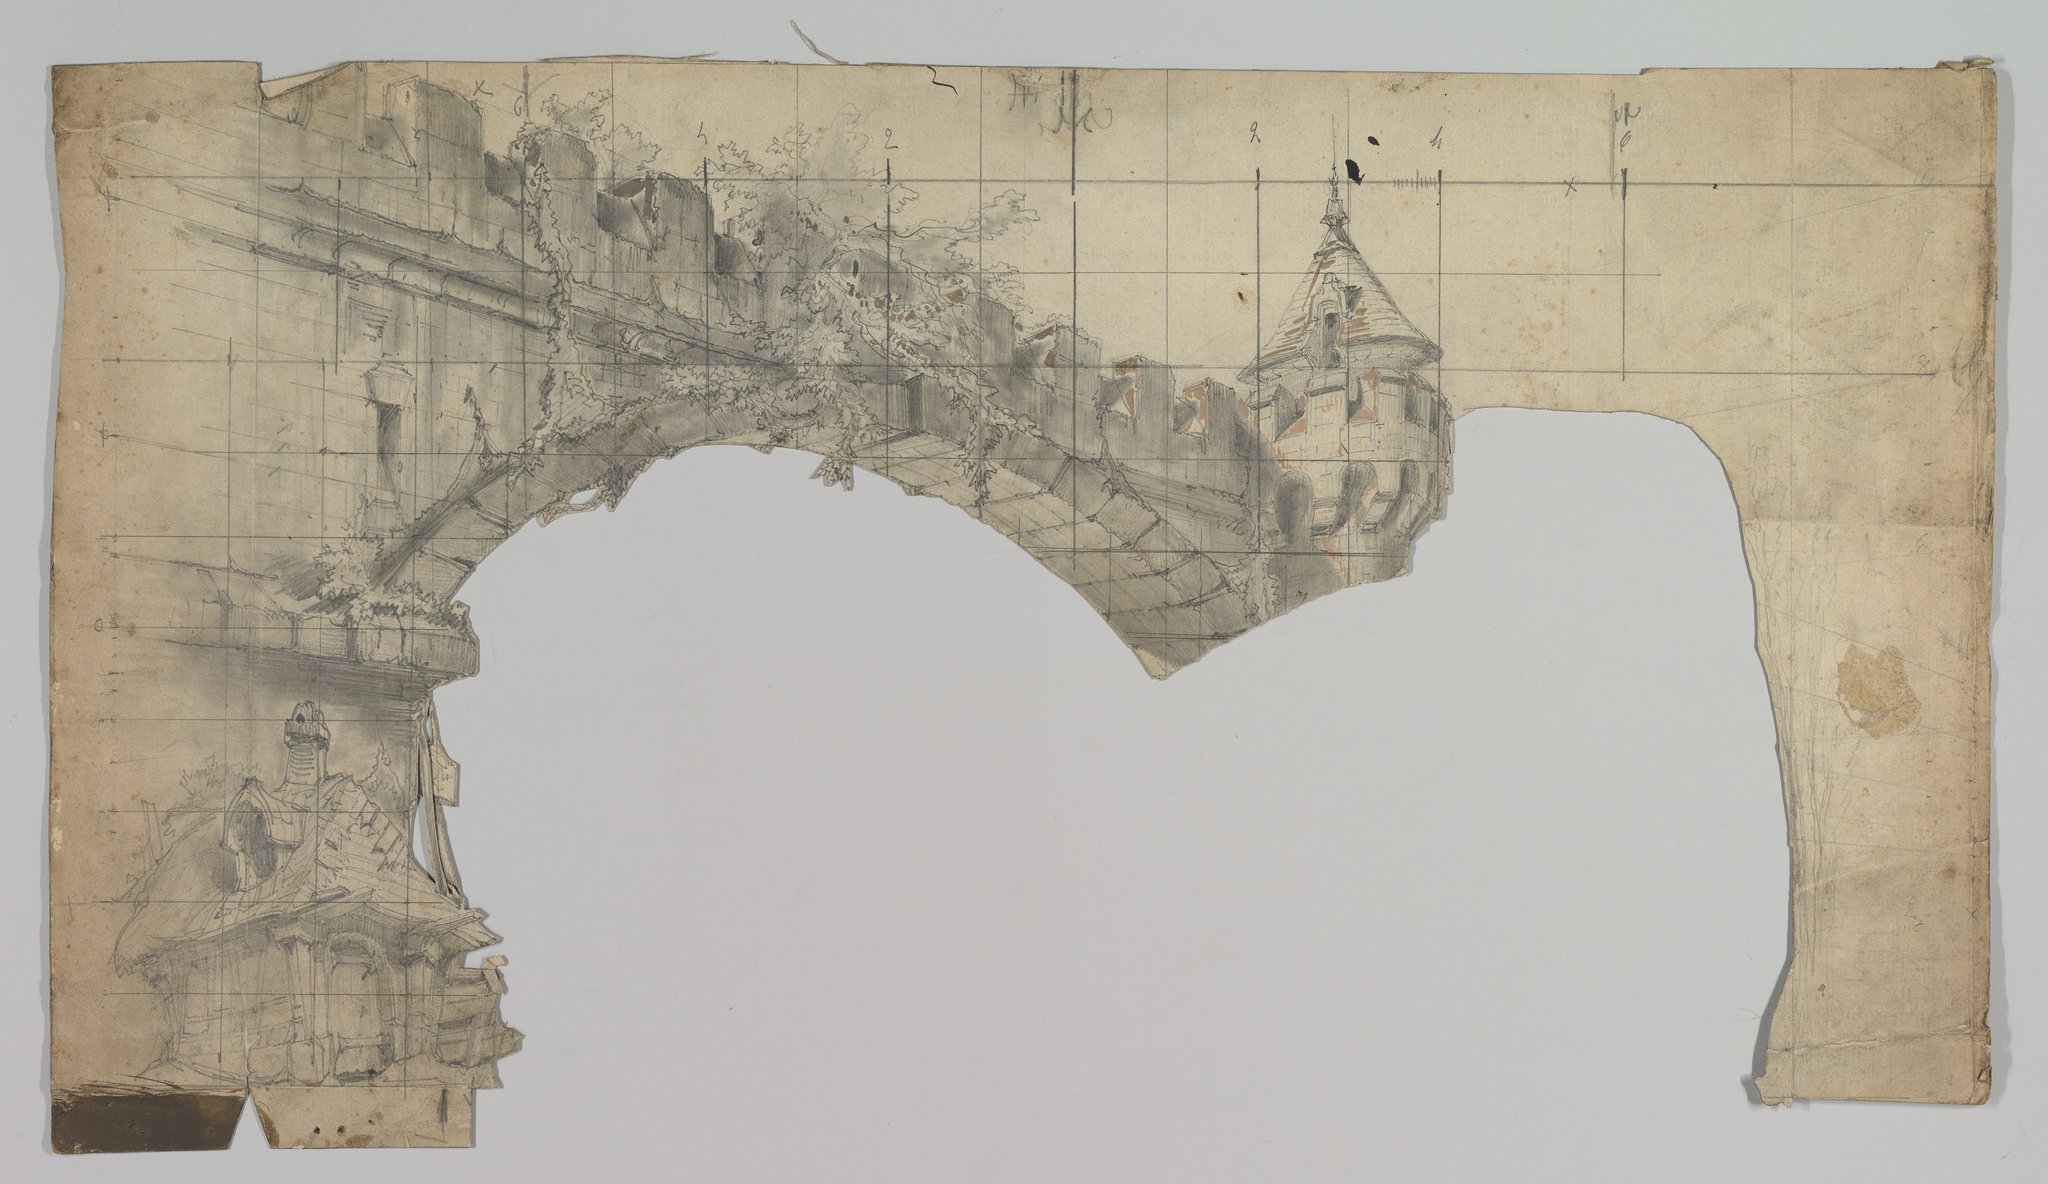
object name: drawing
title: Design for a Stage Set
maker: eugène cicéri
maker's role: artist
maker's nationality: french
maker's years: 1813-1890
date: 1830-1890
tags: stage design